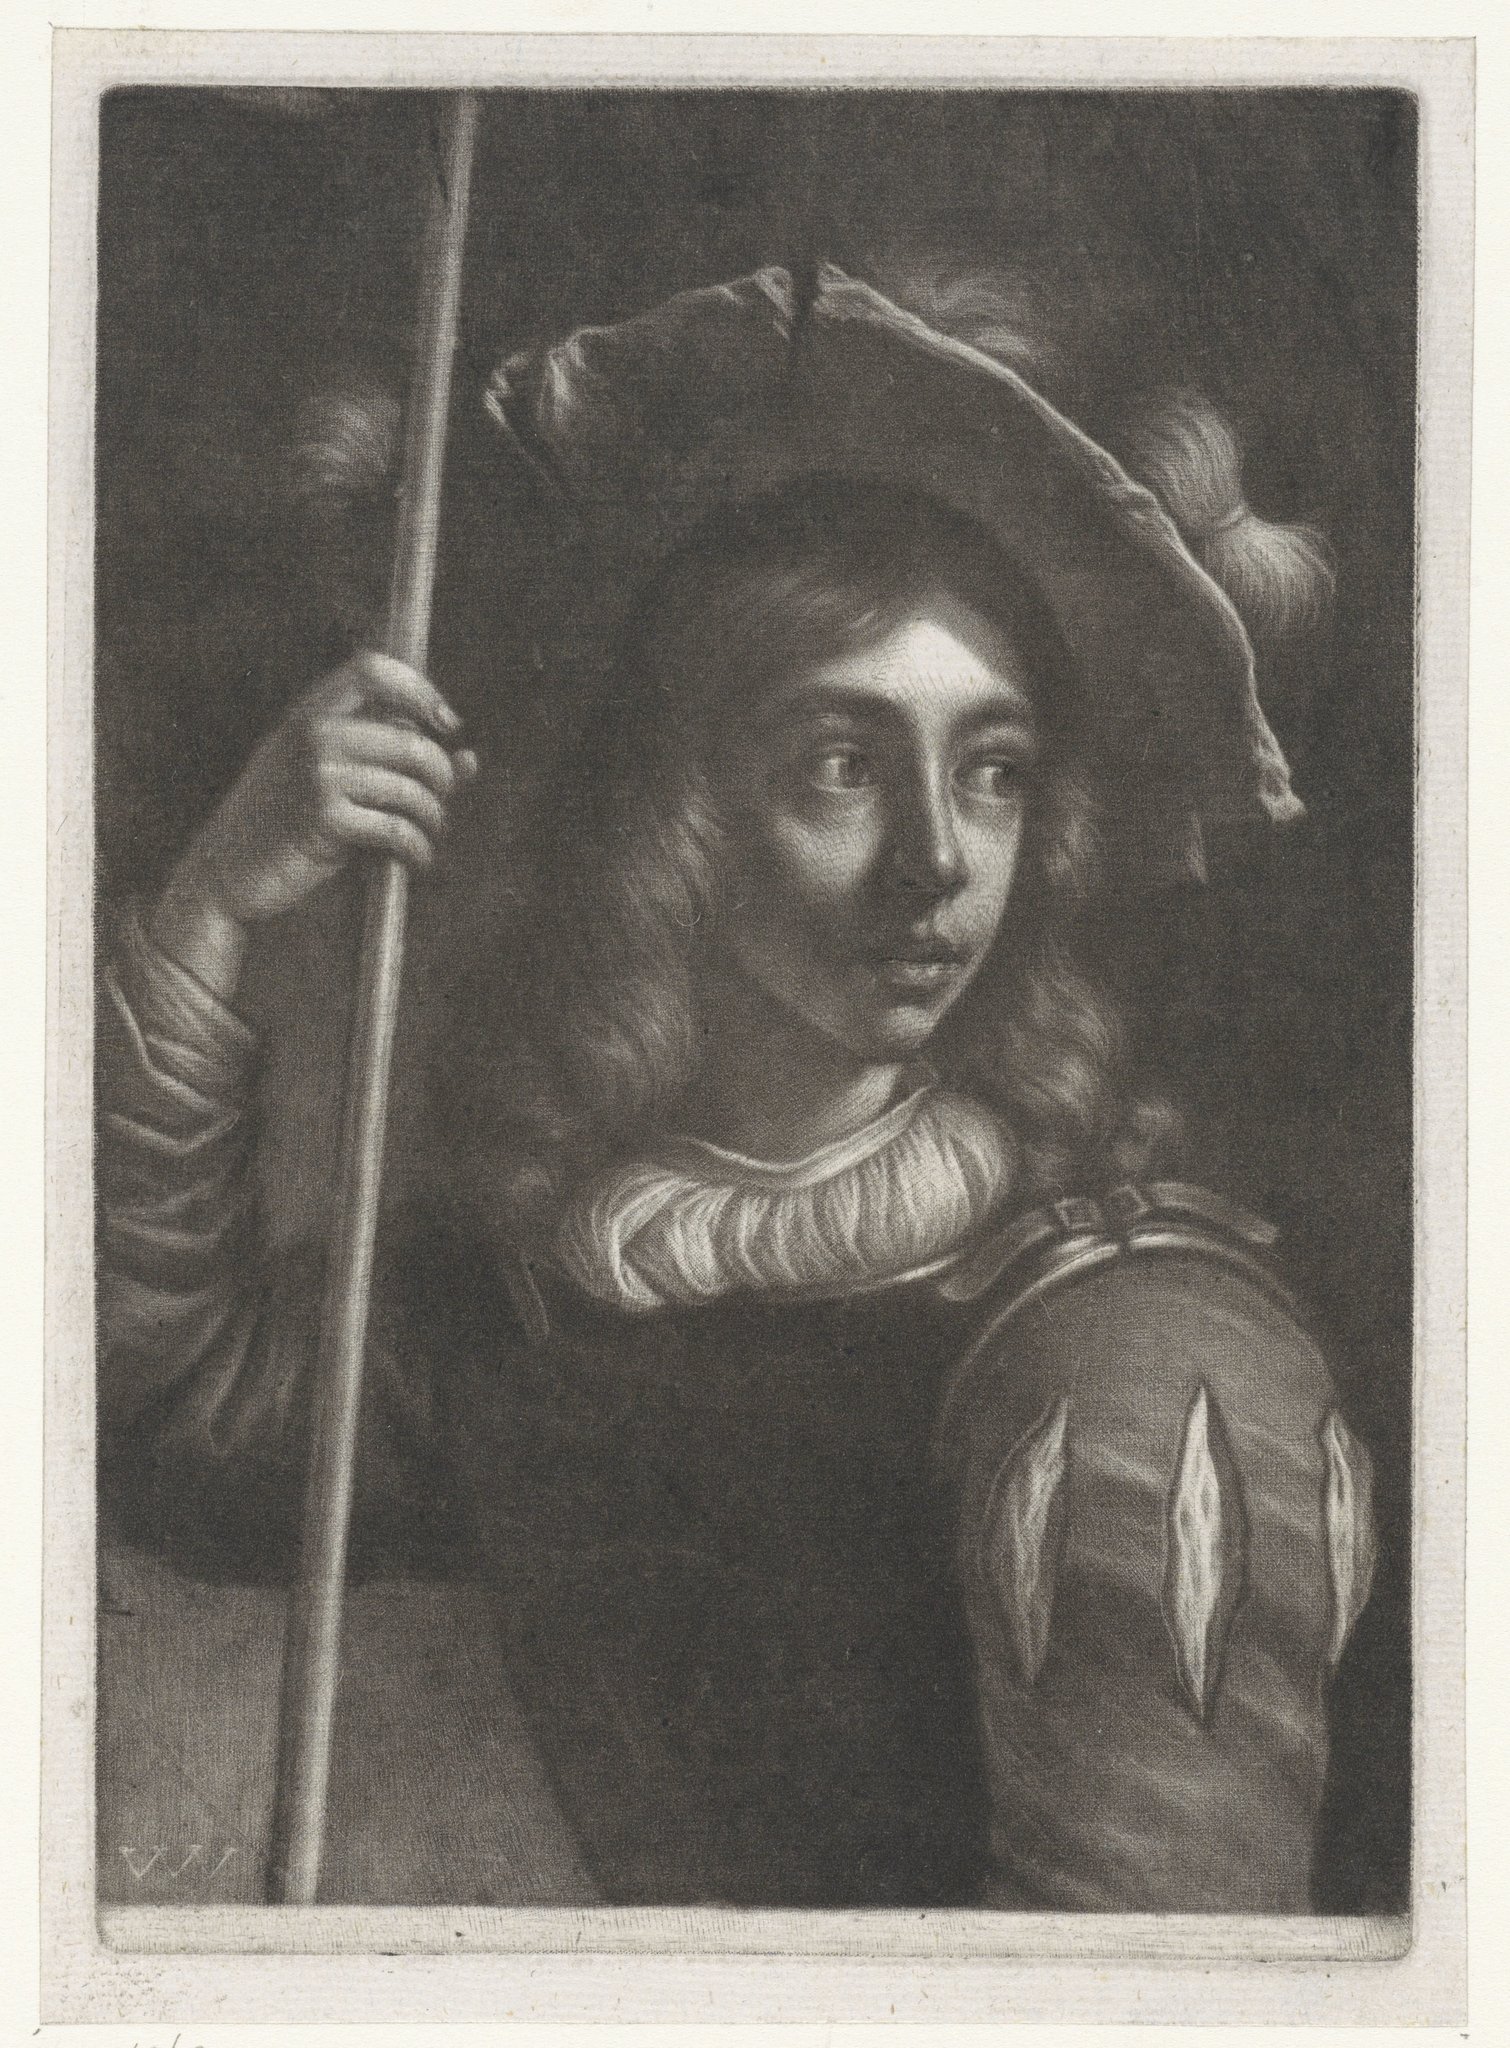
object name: print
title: Vaandeldrager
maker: wallerant vaillant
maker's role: draughtsman, painter, print maker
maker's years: 1623-1677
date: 1658-1677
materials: paper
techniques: mezzotint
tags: standard-bearer, flag-bearer, head-gear: hat (+ men's clothes)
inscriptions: collector's mark: Lugt 1494, collector's mark: Lugt 2228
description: Een jonge vaandeldrager met een gevederde hoed.